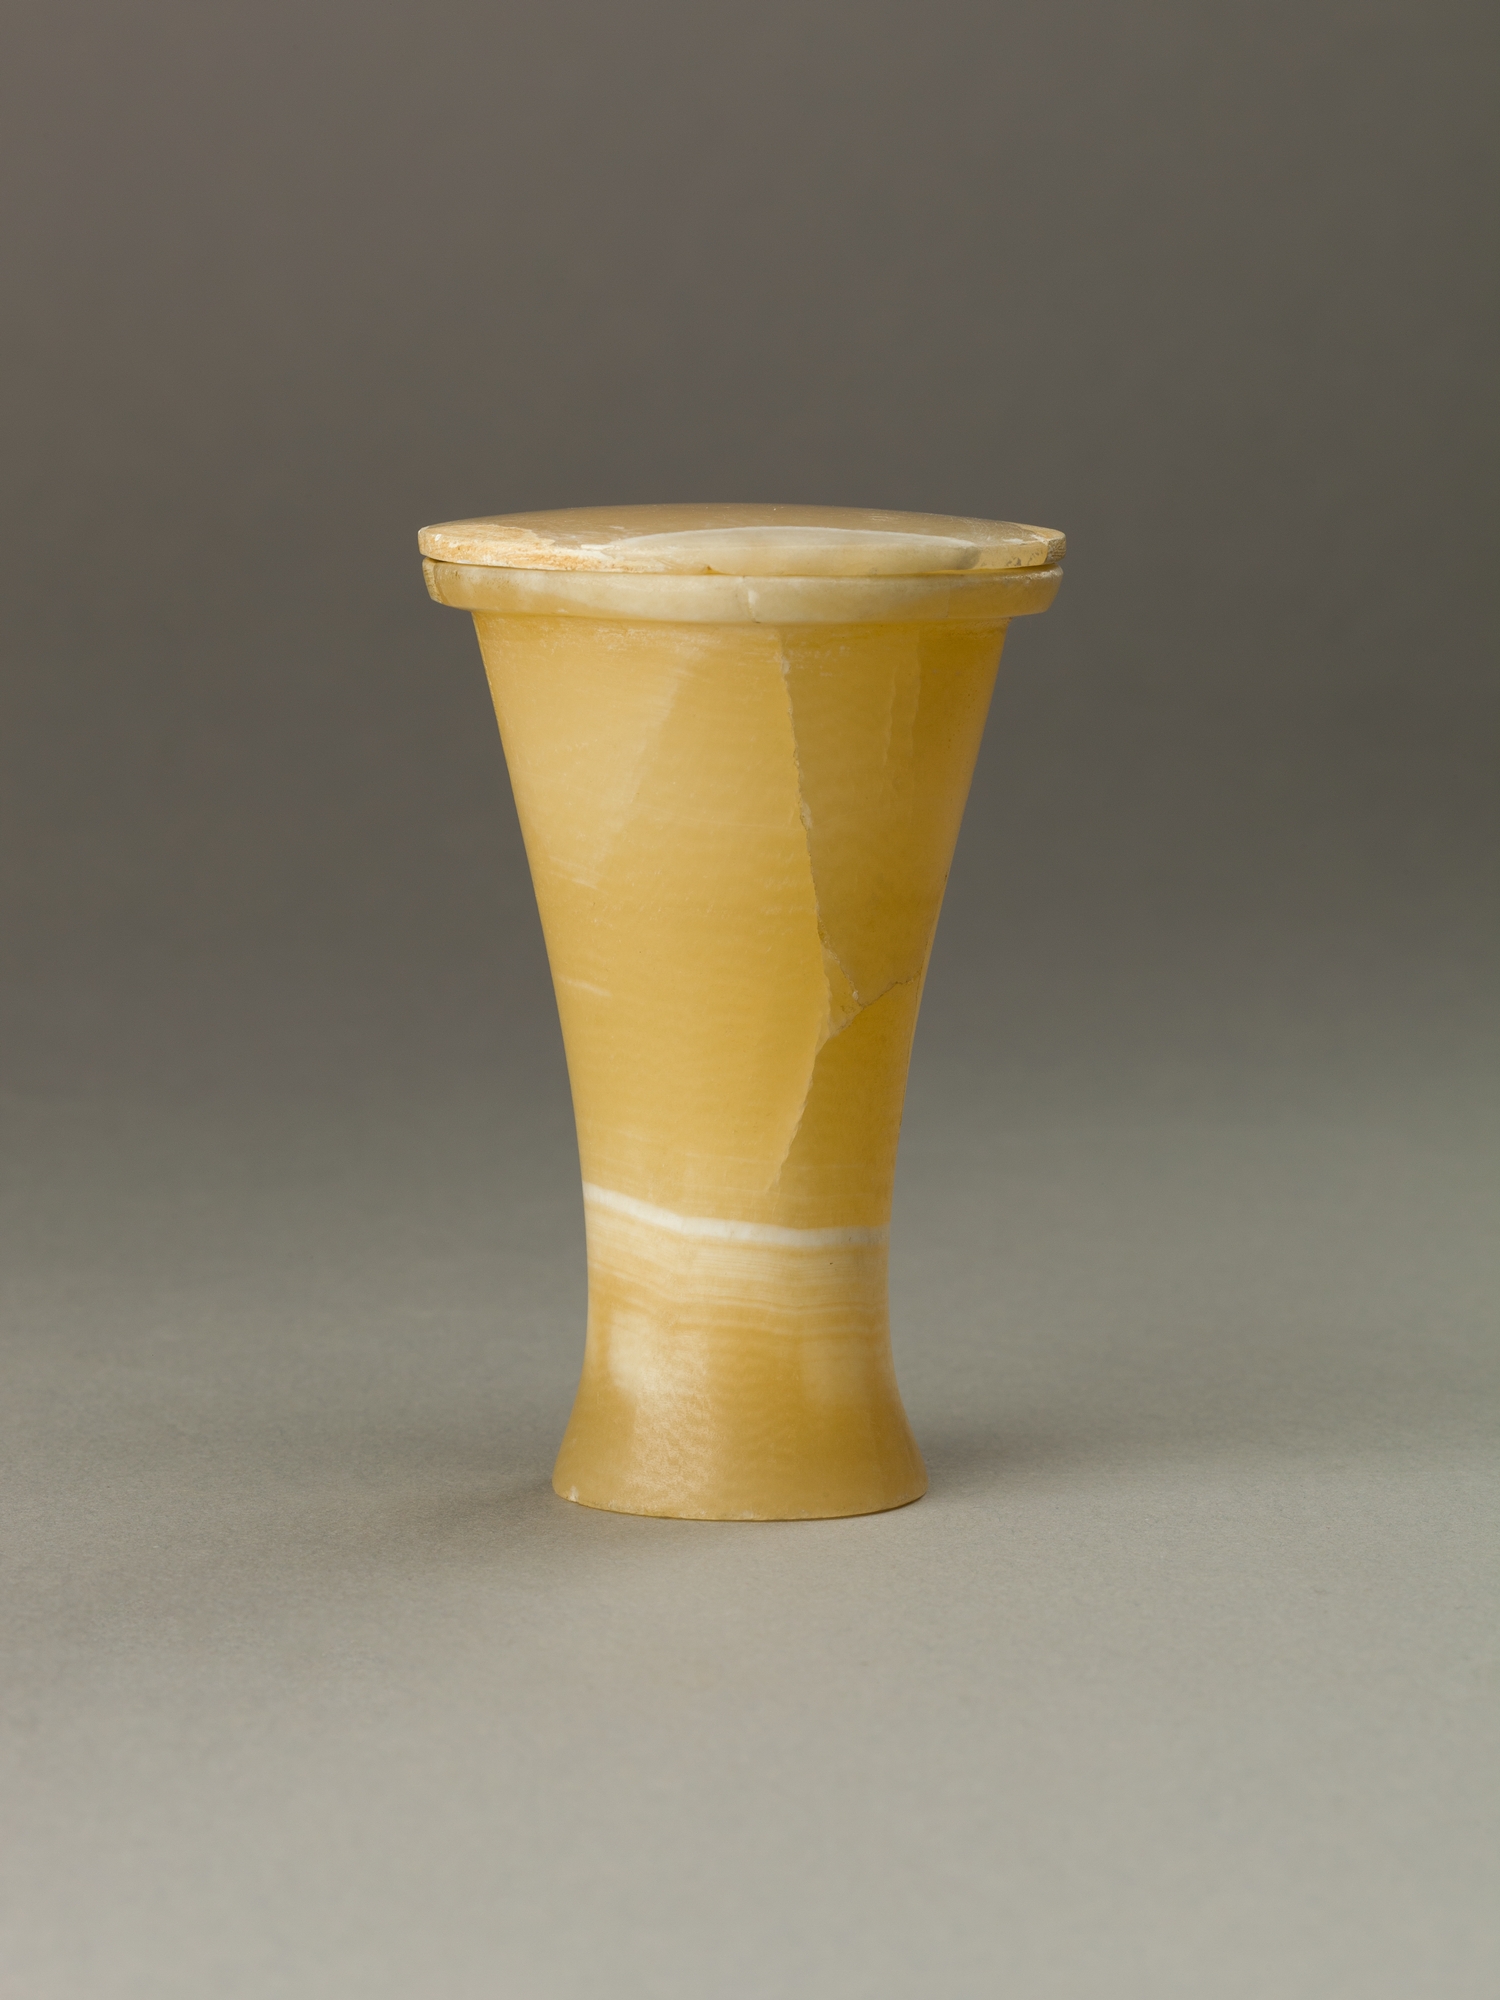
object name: ointment jar, lid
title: Cosmetic jar with lid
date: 1805 BCE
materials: stone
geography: egypt